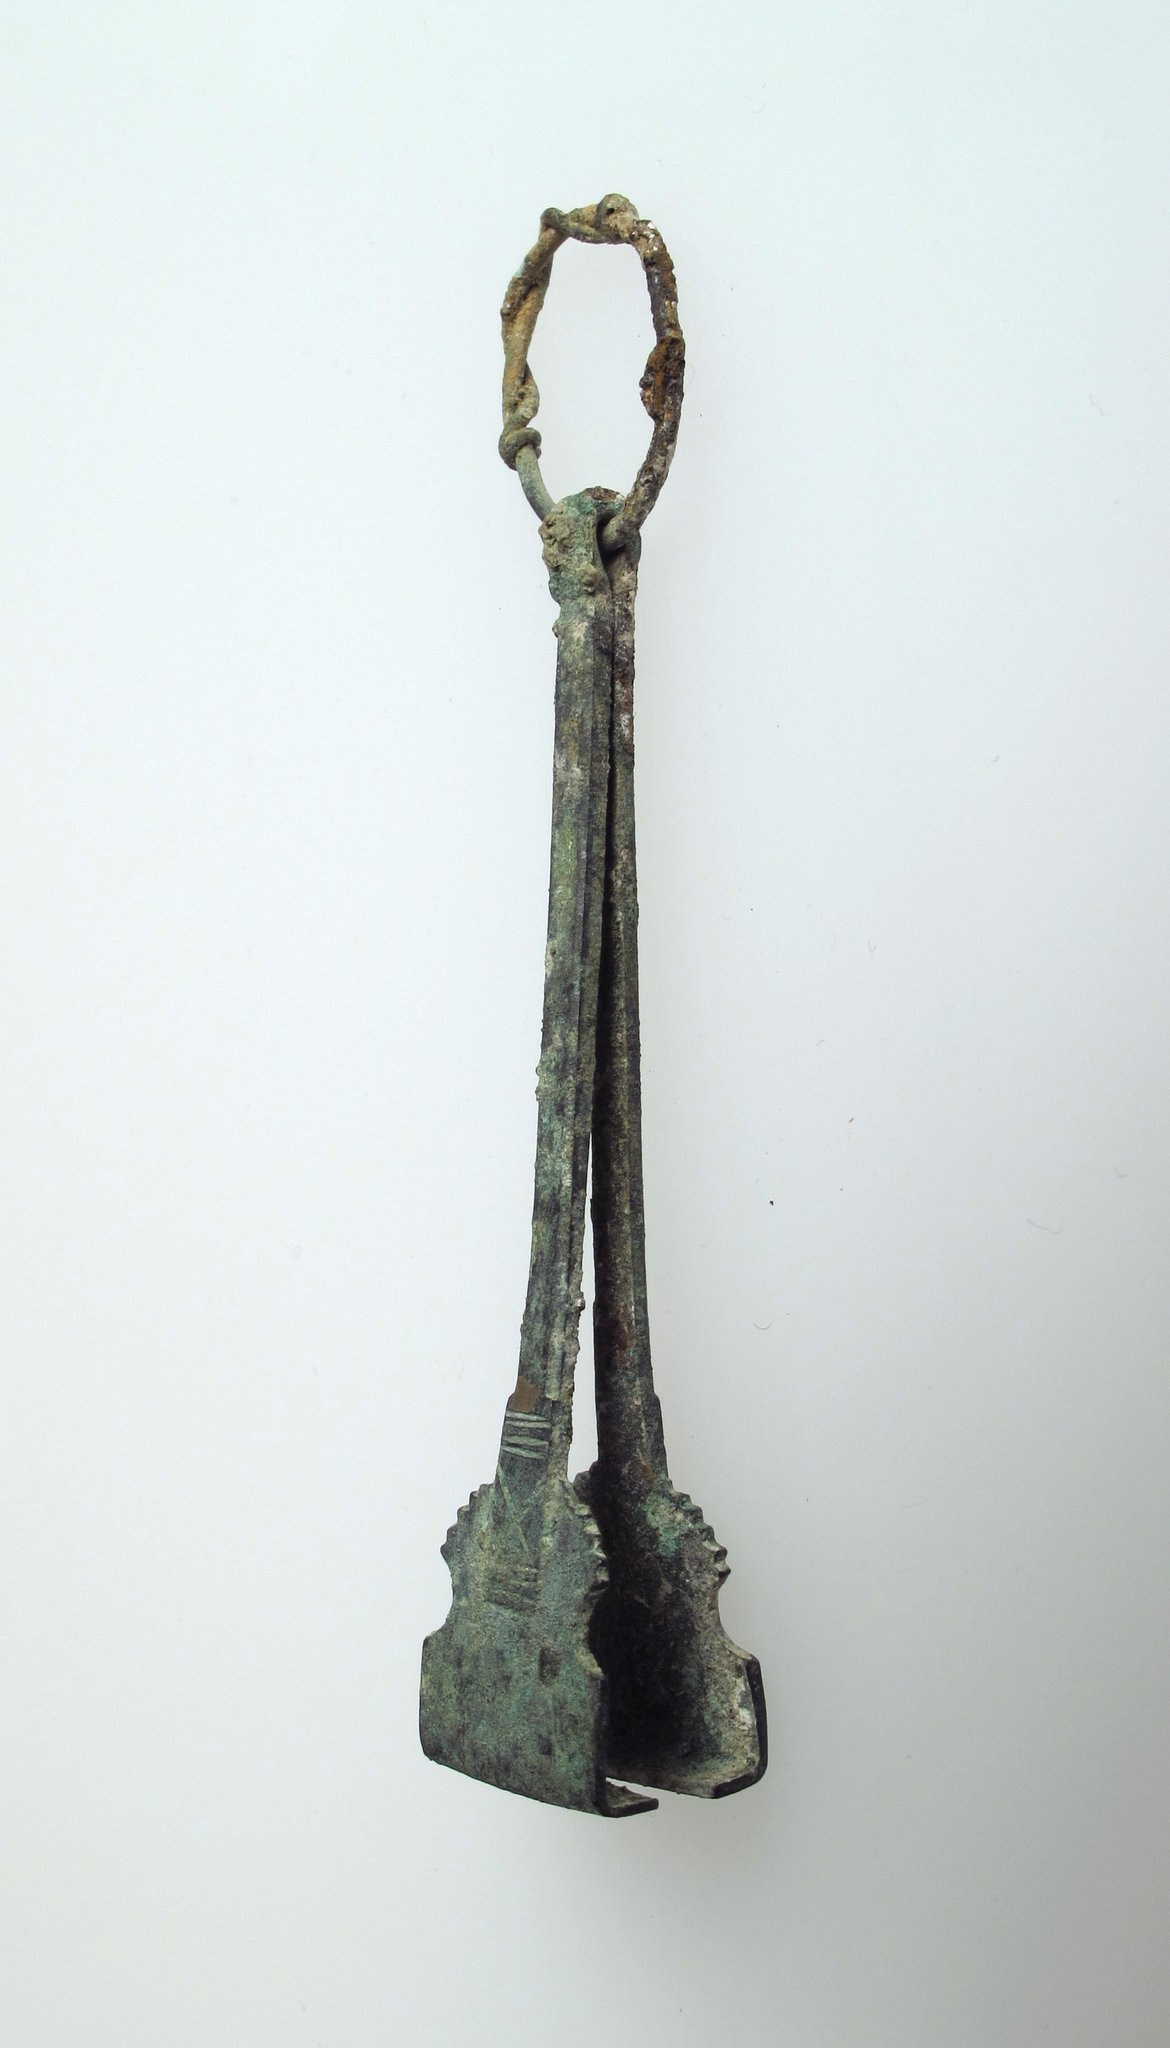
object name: tweezer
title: Tweezers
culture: frankish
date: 601-700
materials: copper alloy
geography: northern france